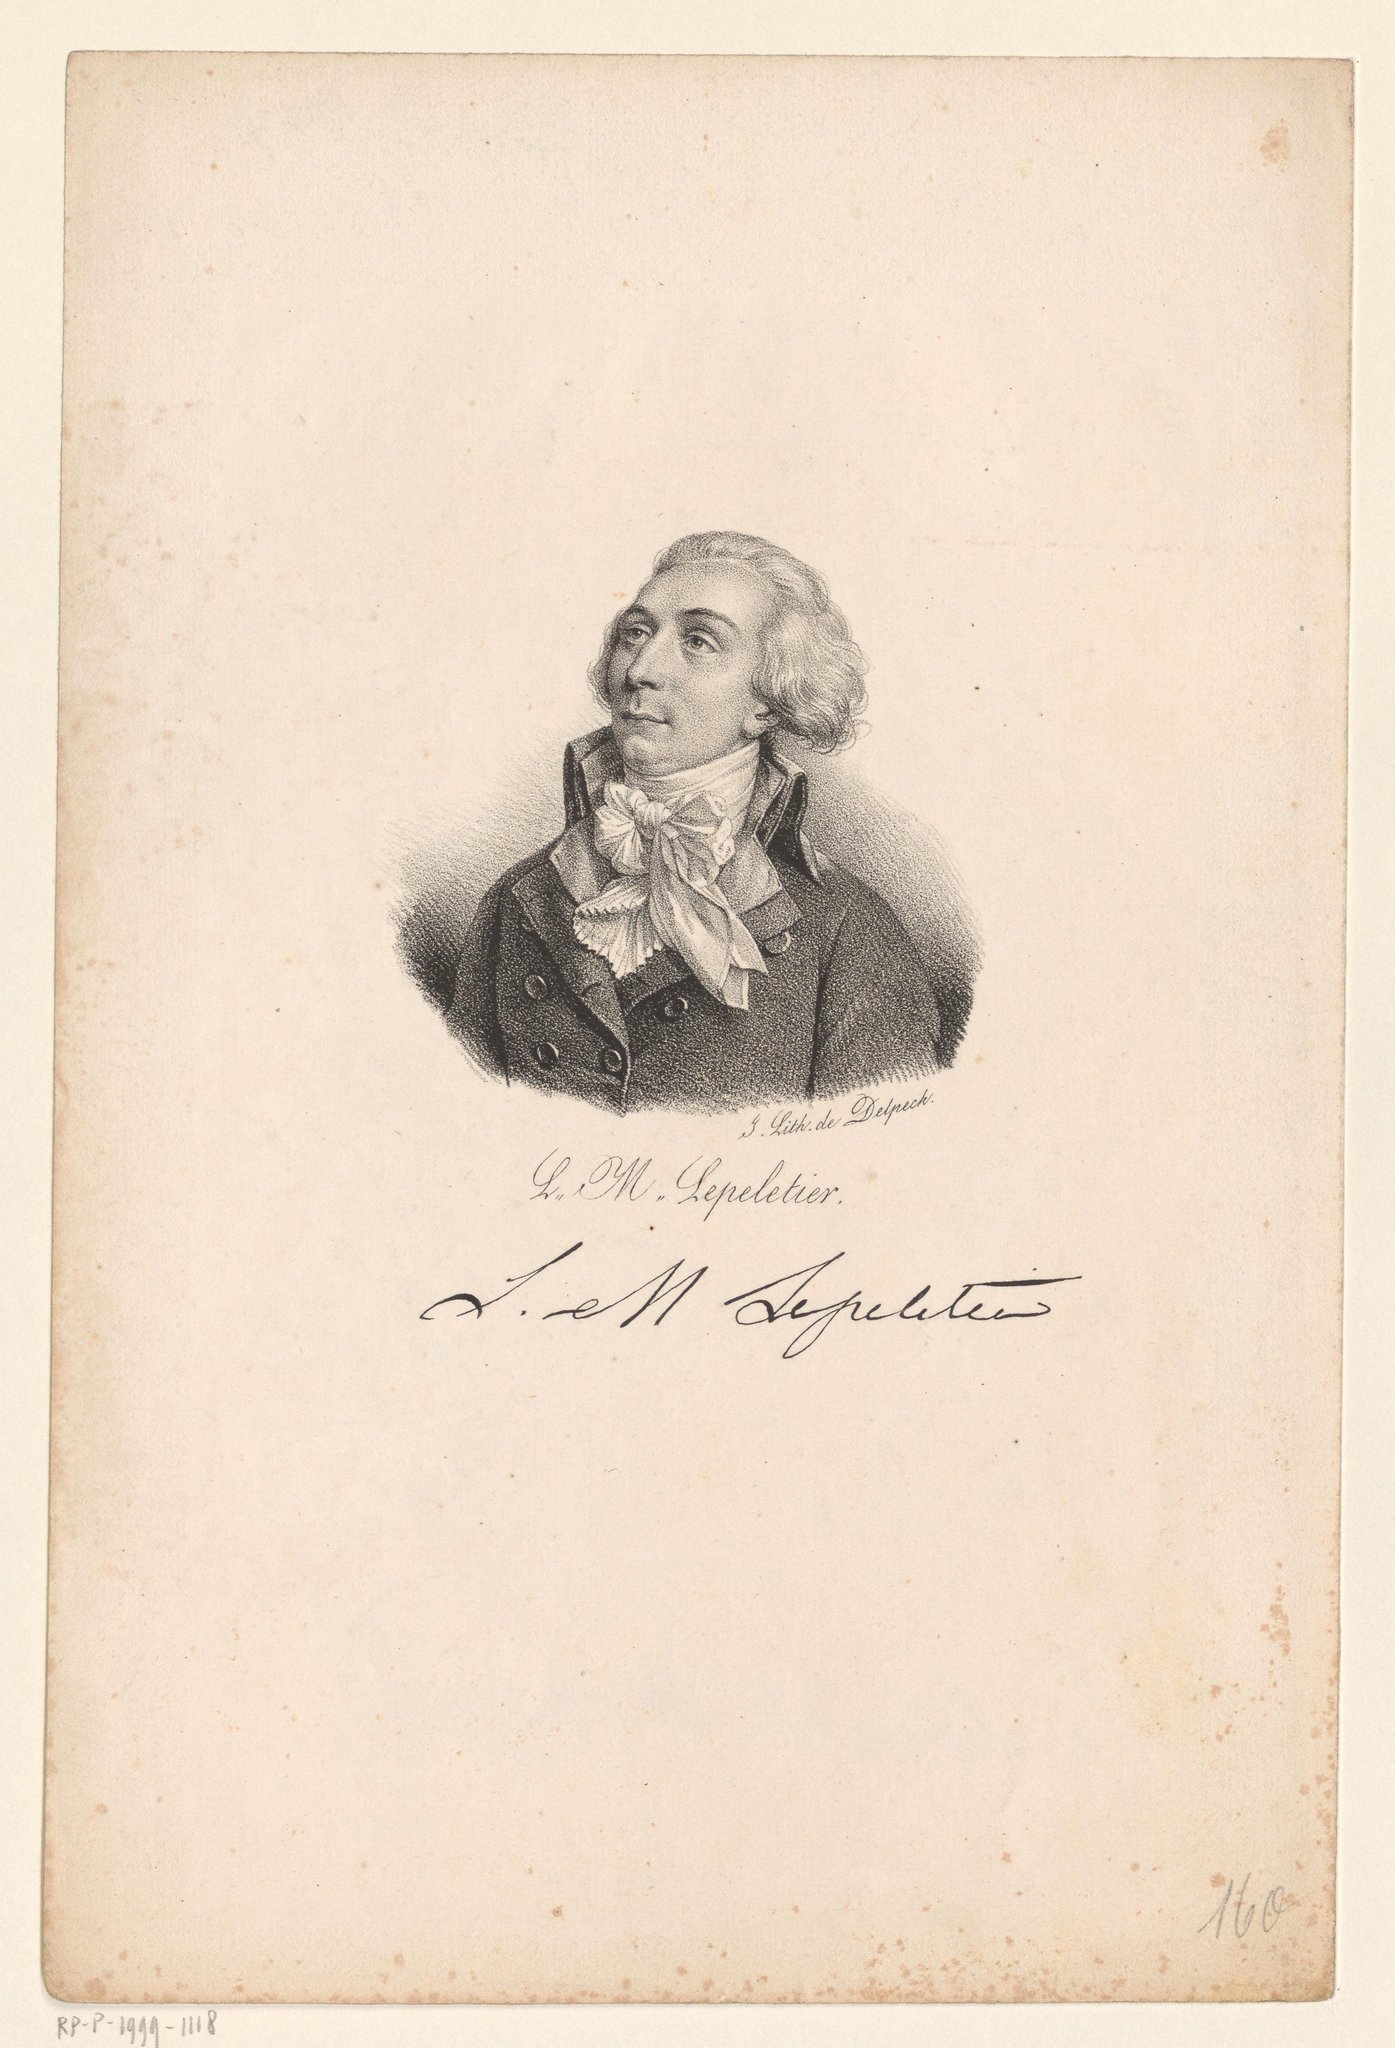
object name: print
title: Portret van Louis-Michel Lepeletier de Saint-Fargeau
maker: Anonymous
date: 1818-1842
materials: paper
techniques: lithograph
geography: france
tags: paris, politician, historical persons, politician, e.g. party leader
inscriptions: collector's mark: Lugt 2228